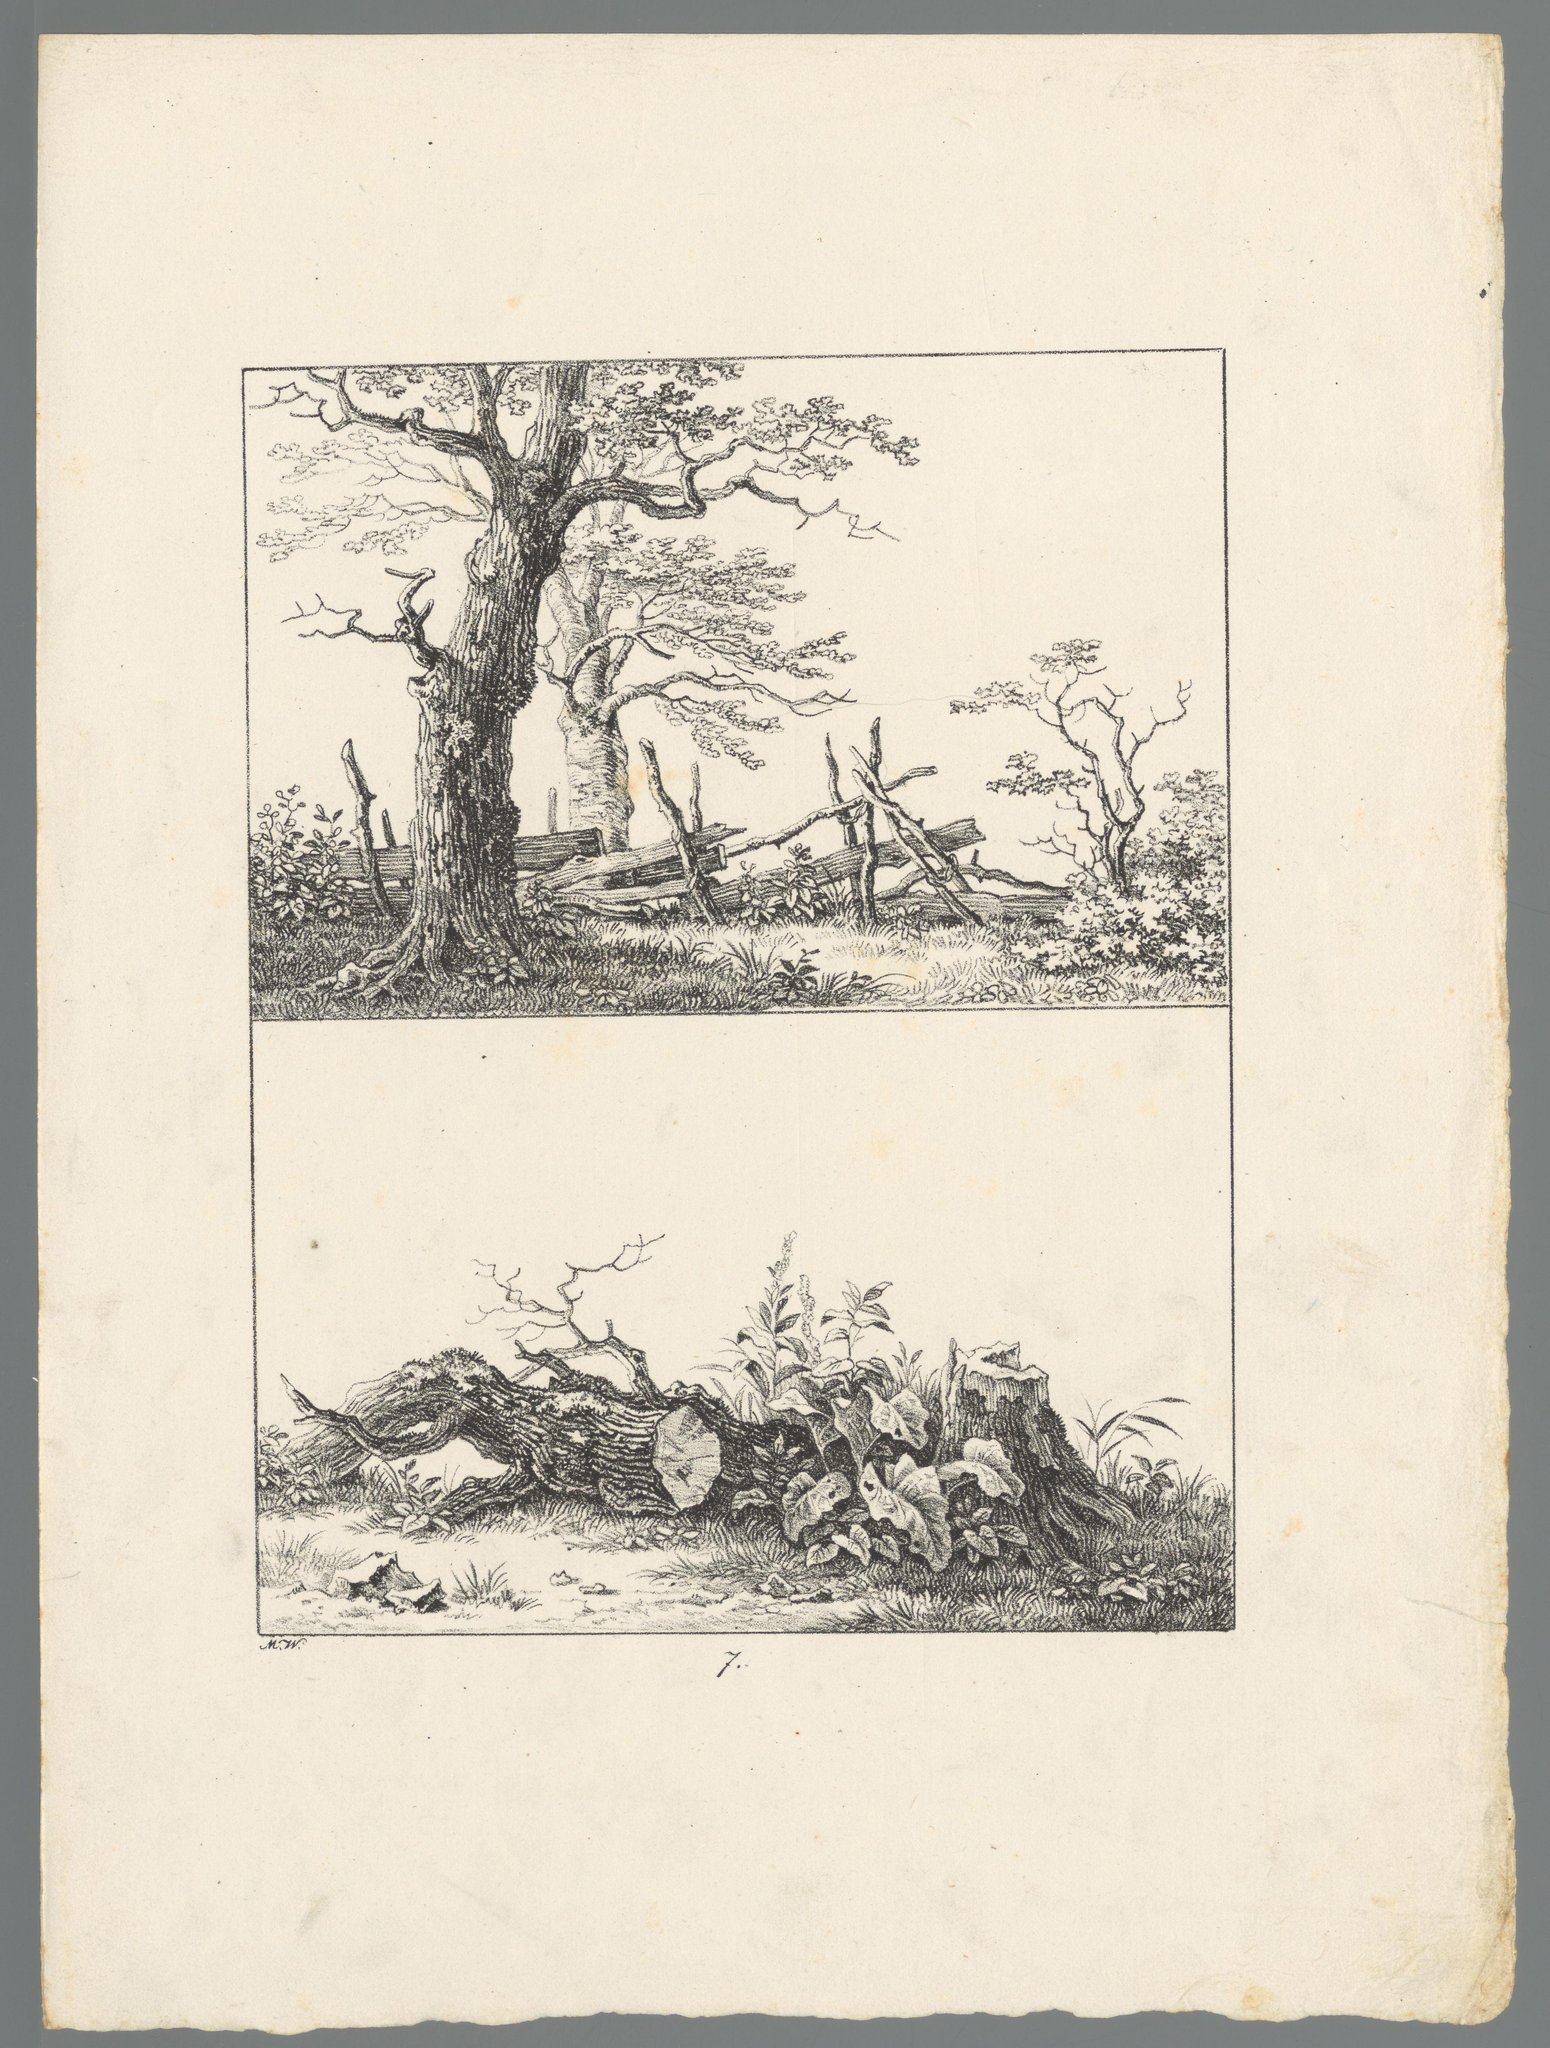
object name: print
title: Landschap met vervallen hekwerk en een boomstronk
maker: max josef wagenbauer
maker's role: print maker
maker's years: 1774-1829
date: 1823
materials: paper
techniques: lithograph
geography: munich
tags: plants; vegetation, trees, fence, wall, paling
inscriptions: collector's mark: Lugt 2228, collector's mark: Lugt 2760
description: Prent behoort tot het eerste deel van de serie 'Vorlagen für Landschaft-zeichner'. Dit eerste deel bevat twintig prenten.